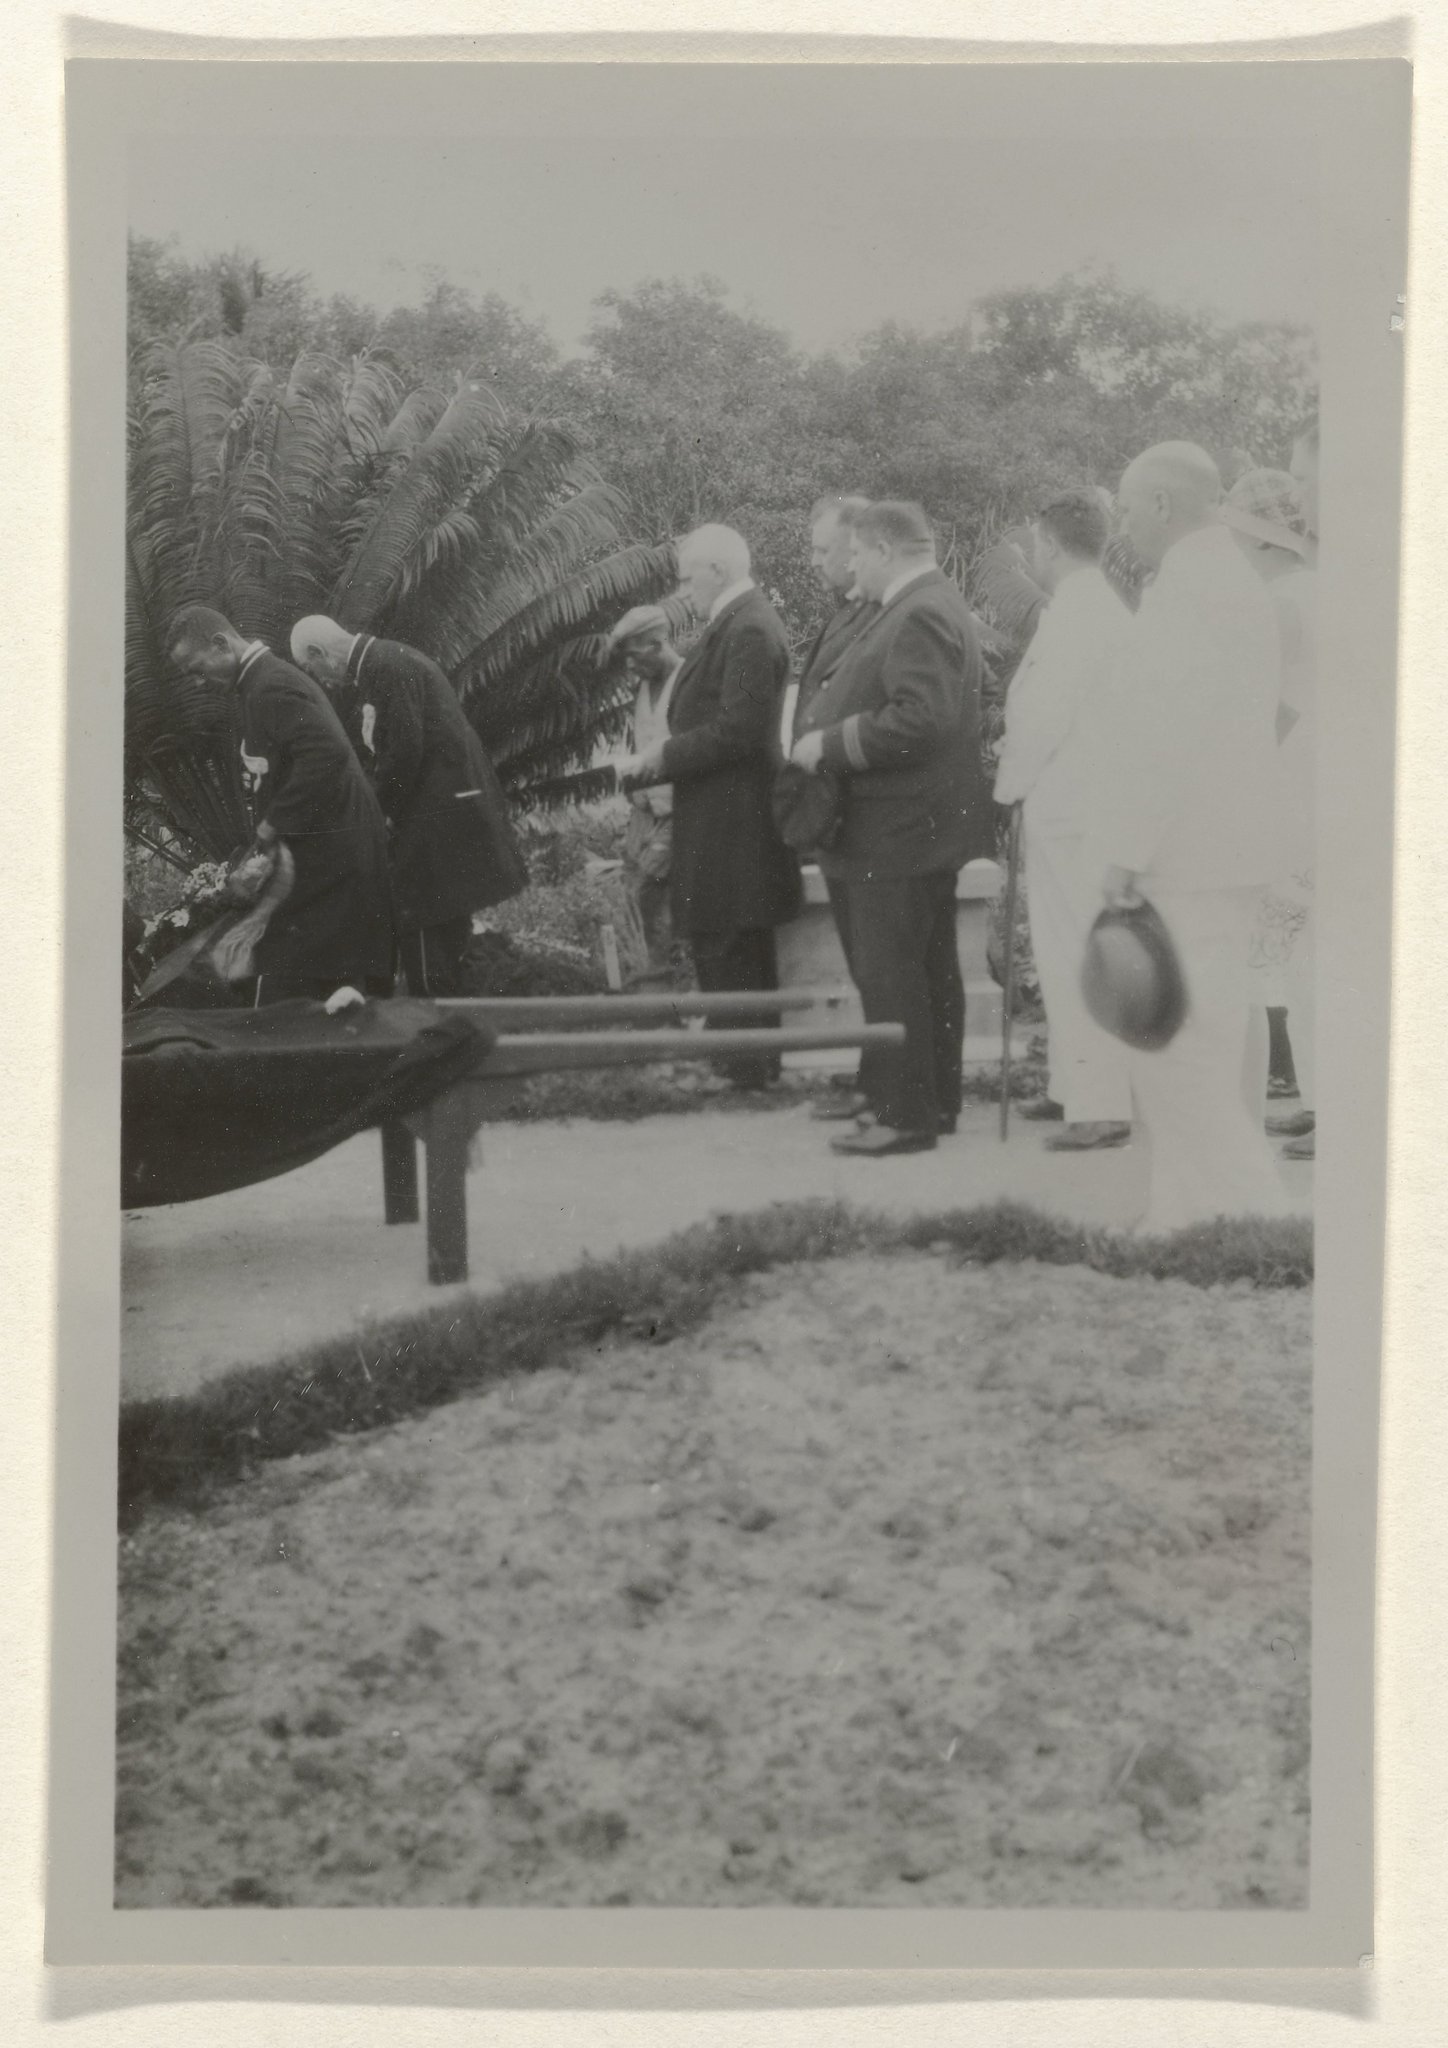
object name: photograph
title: Begrafenis in Moengo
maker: Anonymous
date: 1929-1930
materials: photographic support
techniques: photography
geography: suriname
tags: burial